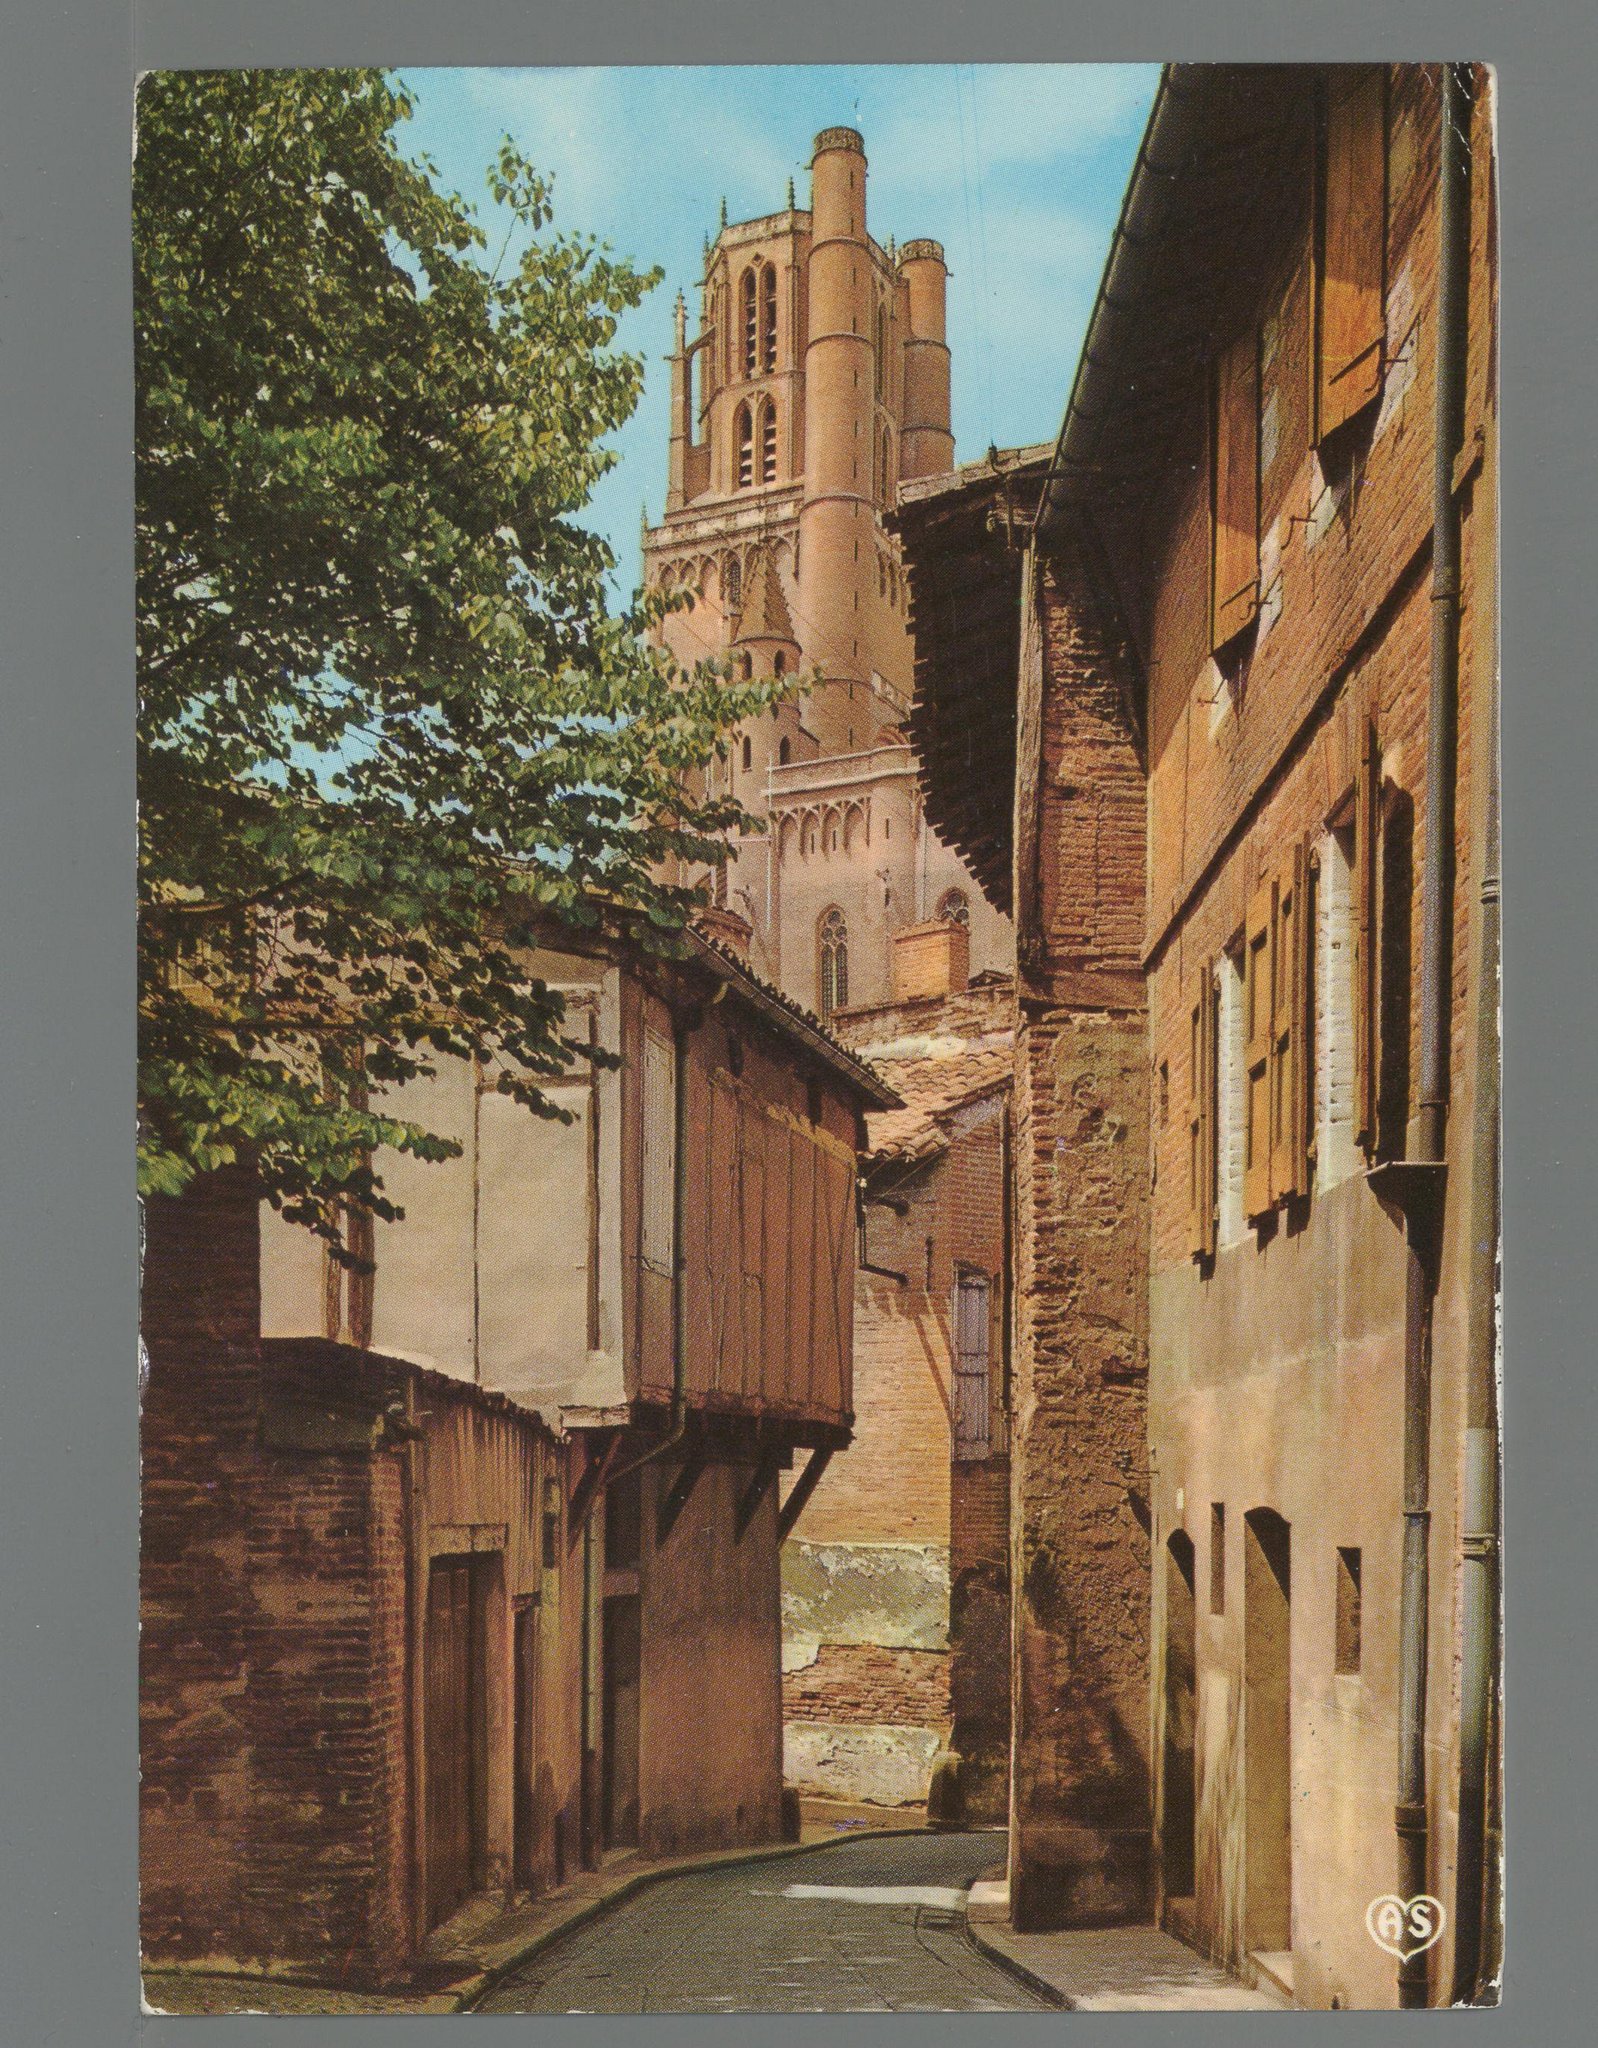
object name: photomechanical print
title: Albi (Tarn) (...) D'une rue pittoresque du vieil Albi, echappée sur le clocher de la Basilique Ste Cécile (XIIIo. s.)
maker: Anonymous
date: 1958-1976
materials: cardboard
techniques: offset printed, writing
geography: septèmes-les-vallons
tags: urban housing, church (exterior), street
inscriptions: postage stamp